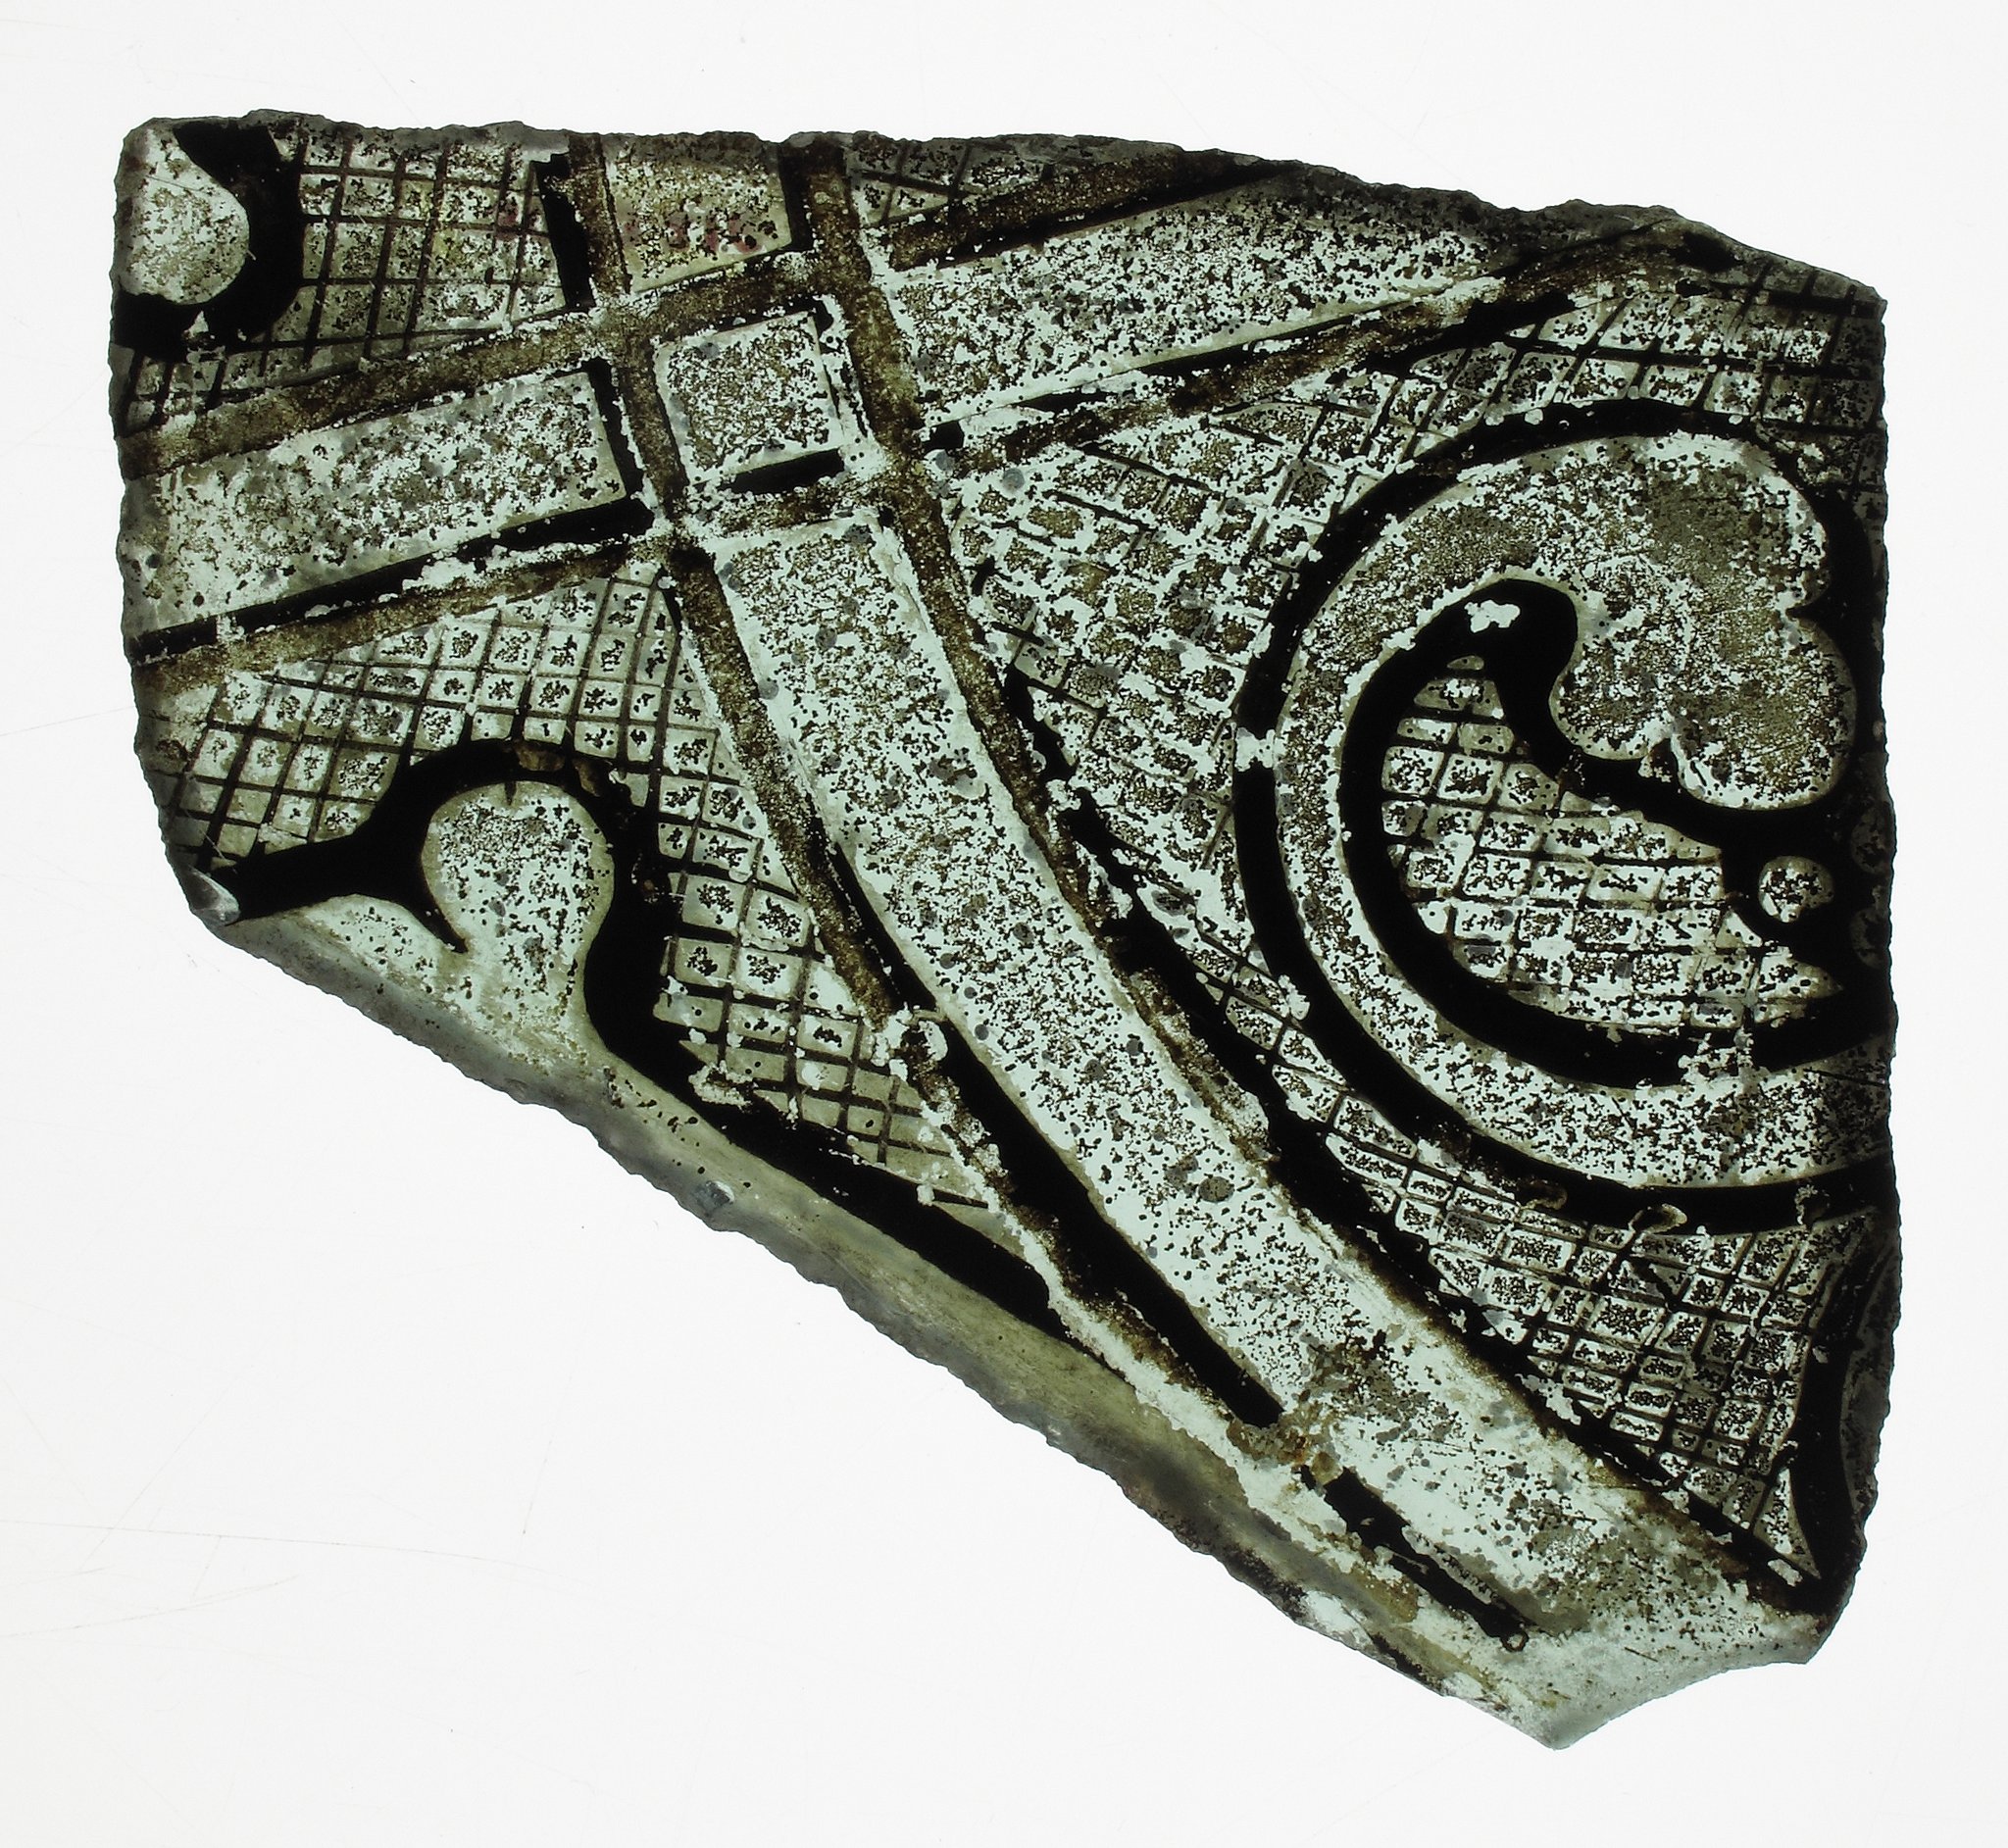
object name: fragment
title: Glass Fragment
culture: french or british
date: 1300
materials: glass